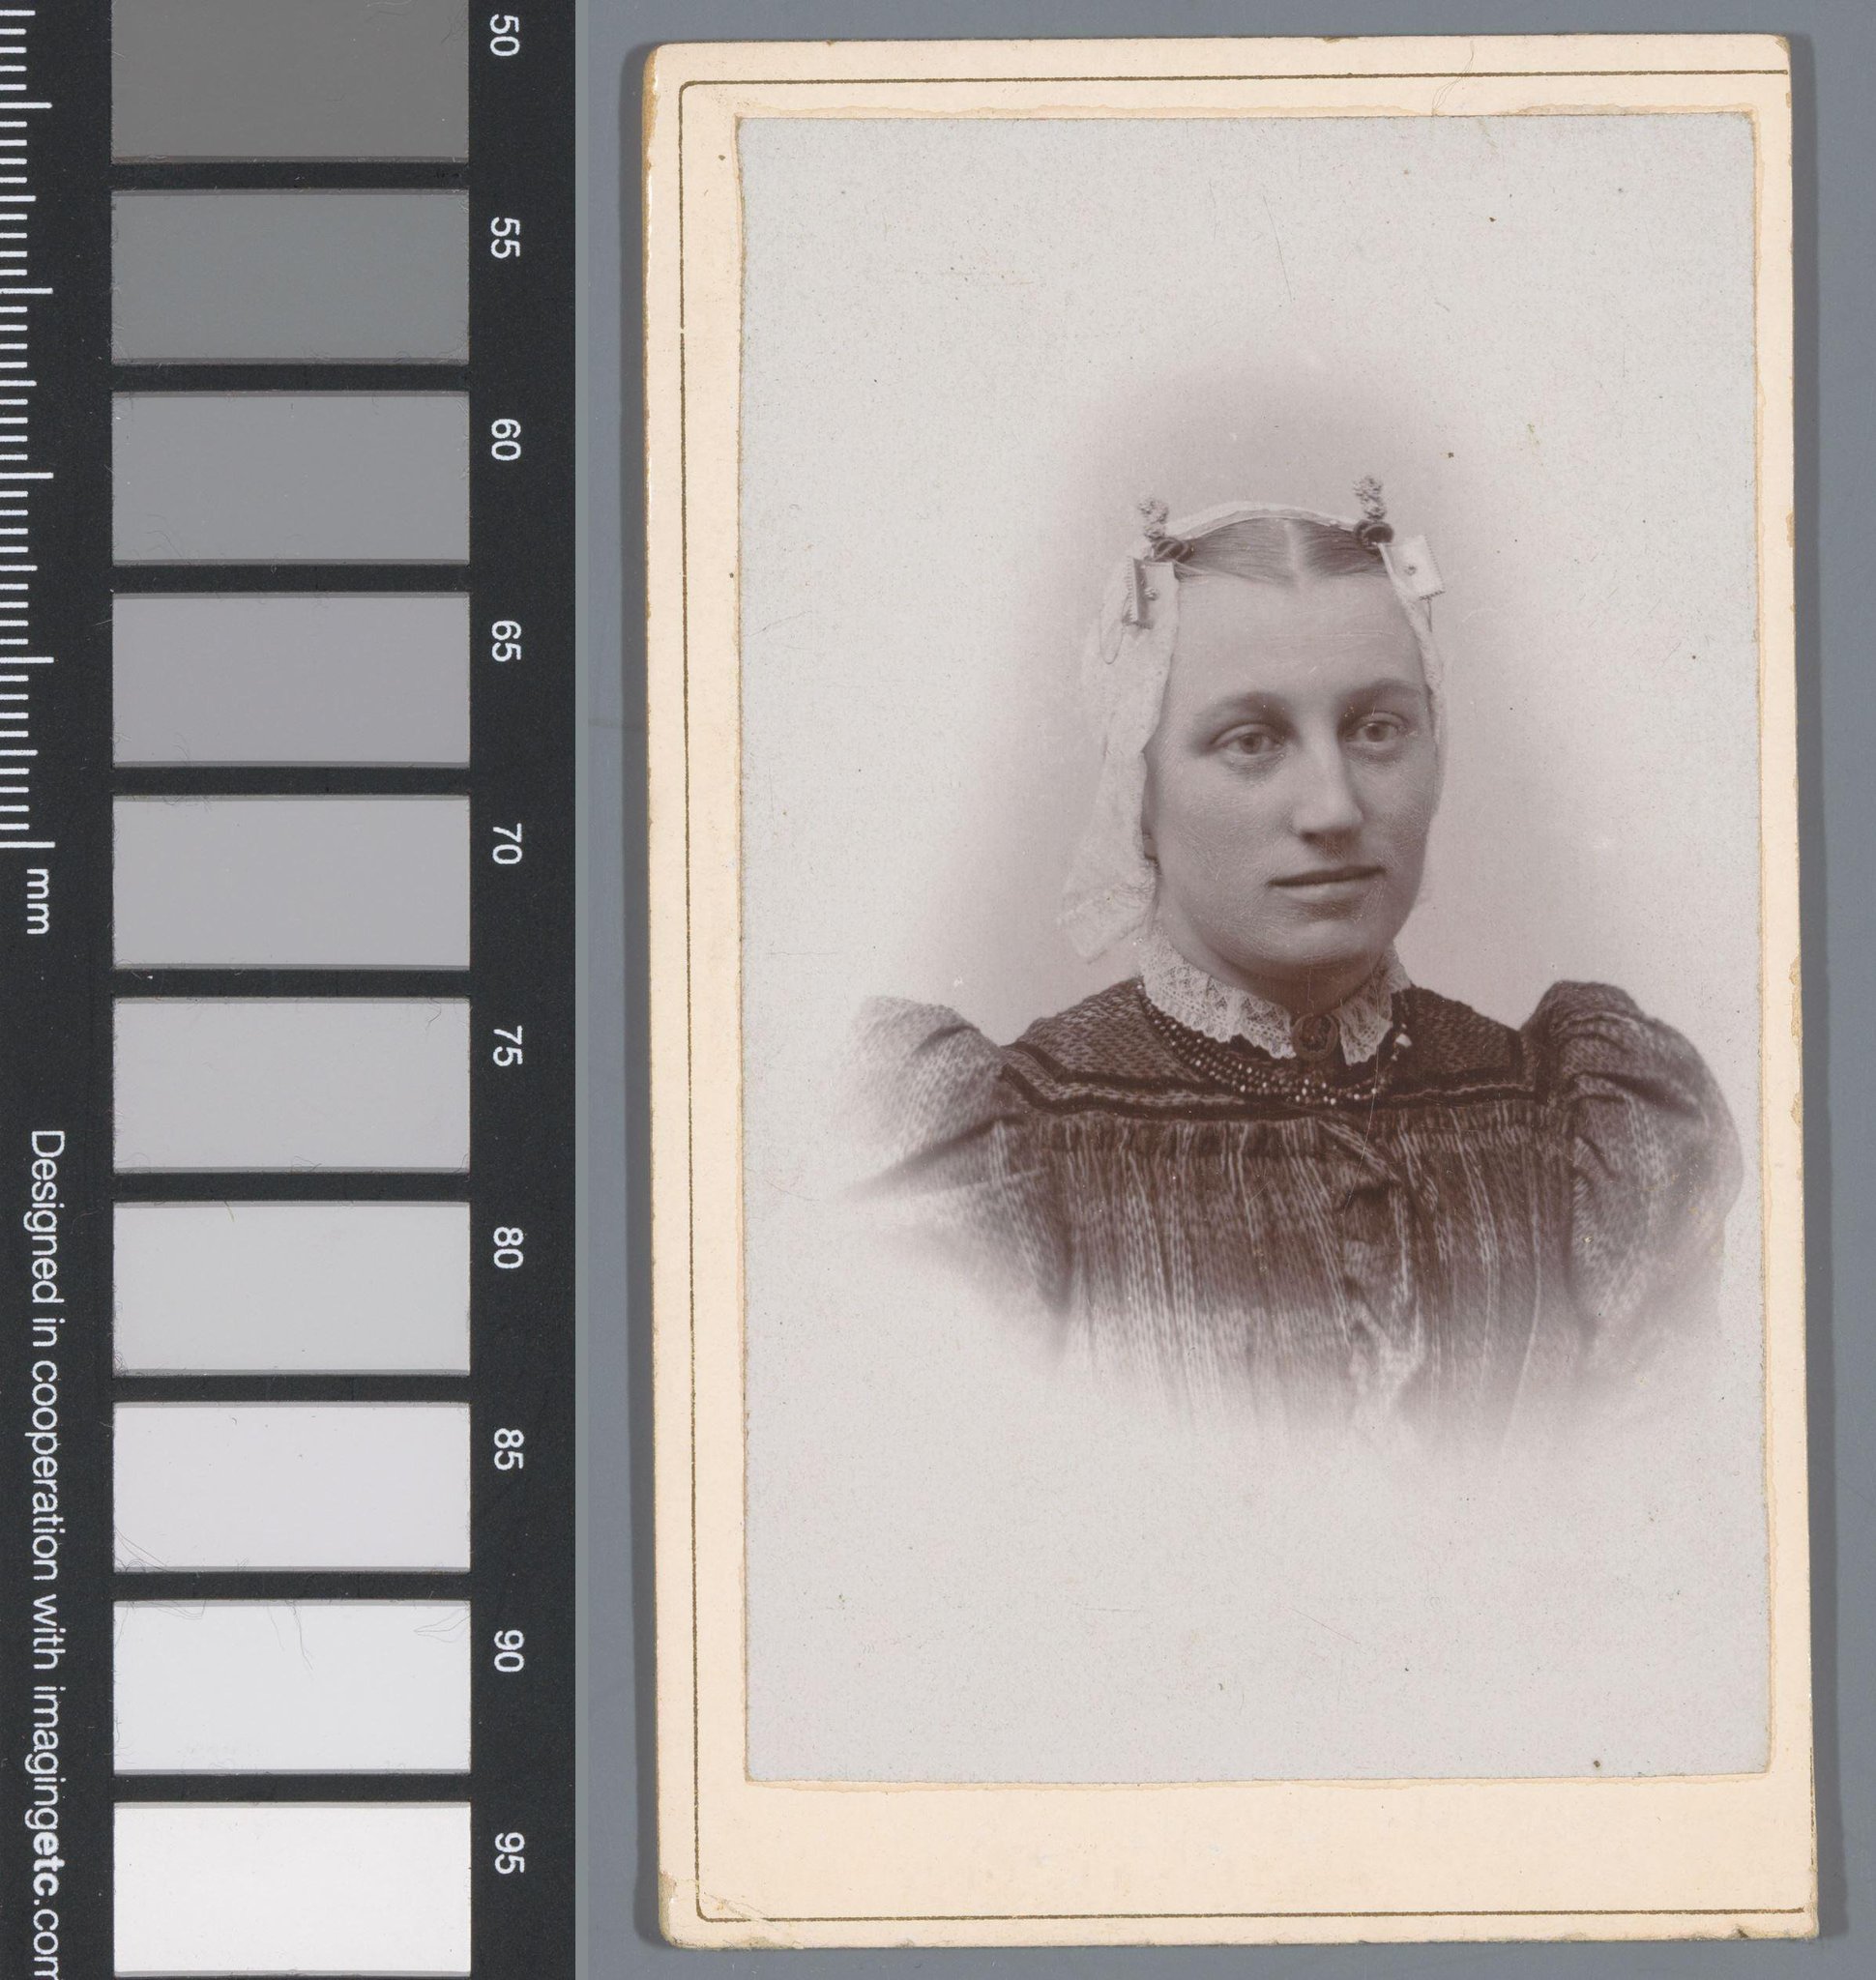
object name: photograph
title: Portret van Neeltje Buurs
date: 1894-1898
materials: cardboard, photographic support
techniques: collodion silver print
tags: historical persons - bb - woman, head-gear: cap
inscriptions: stamp: ‘Gebrs. IJPMA./ FOTOGRAFEN./ EDAM/ VOORHAVEN./ WORMERVEER/ WANDELWEG’, inscription: ‘Neeltje Bruins A.d.’